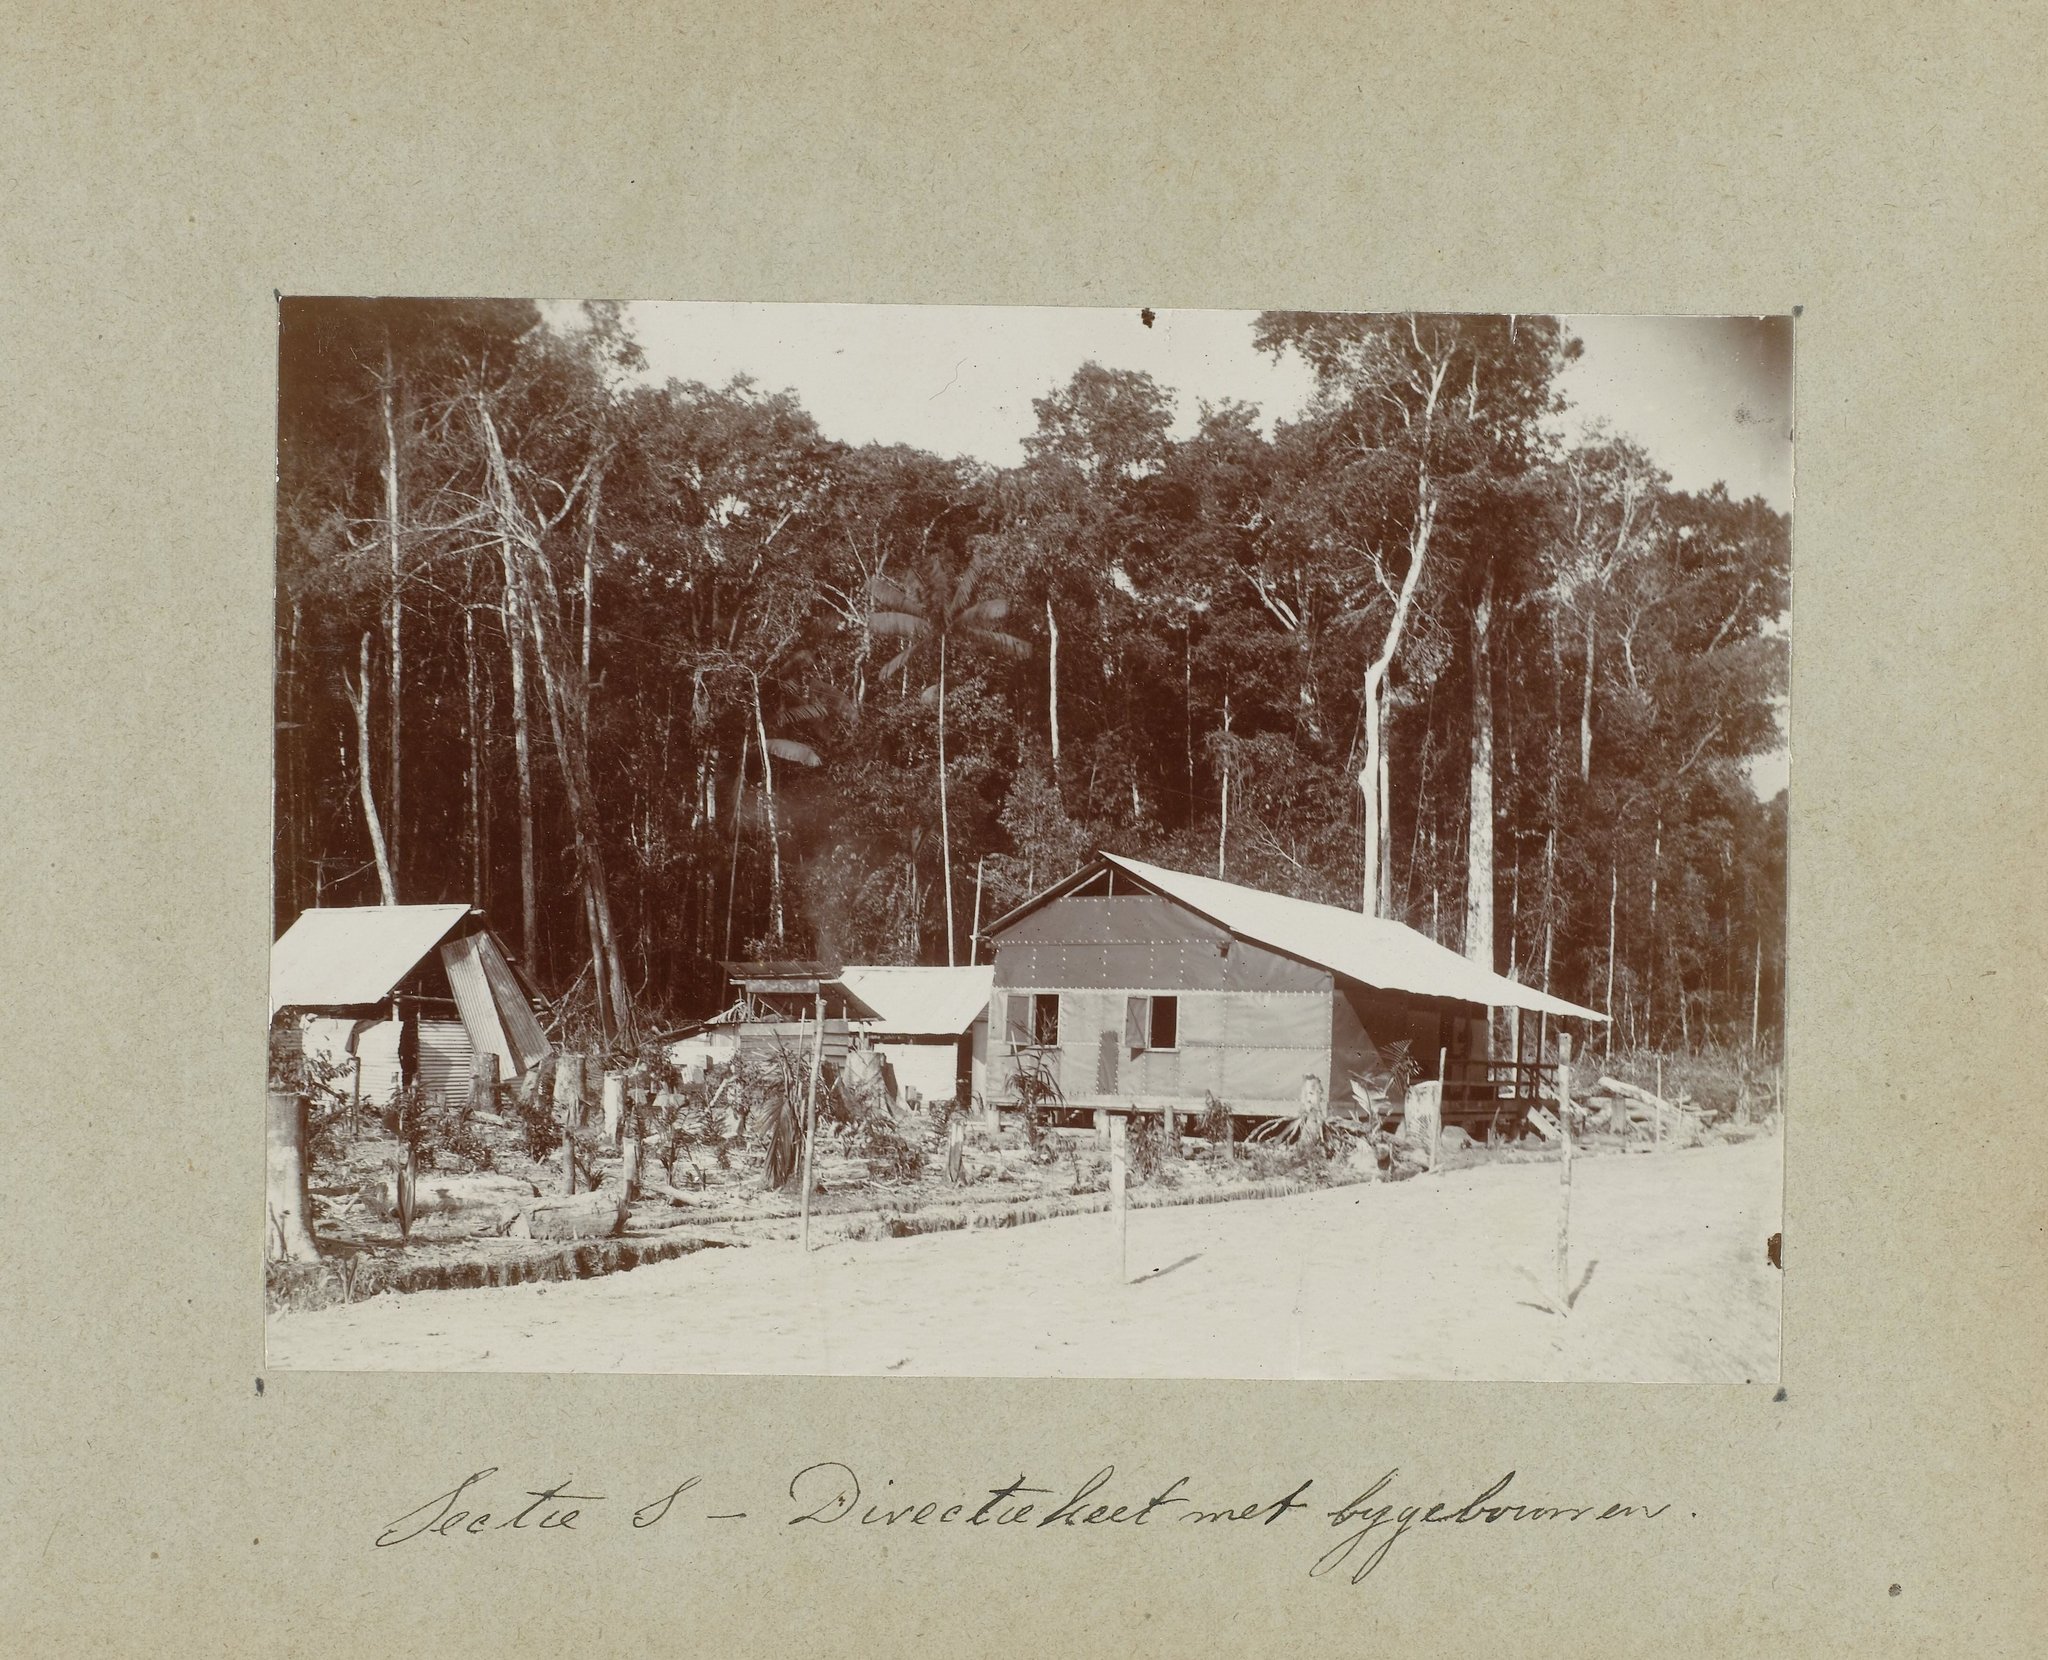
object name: photograph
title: Sectie S - Directiekeet met bijgebouwen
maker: augusta curiel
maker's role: fotograaf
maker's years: 1873-1937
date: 1905-1910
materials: photographic support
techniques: photography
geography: suriname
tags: jacob evert wesenhagen, railway, tramway; rack railway, suriname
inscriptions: inscription: ‘Sectie S - Directiekeet met bijgebouwen’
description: De directiekeet met bijgebouwen in sectie S. Foto in het fotoalbum over de aanleg van de Lawaspoorweg in Suriname in de jaren 1903-1912. Onderdeel van een groep objecten afkomstig van de familie Wesenhagen in Suriname.